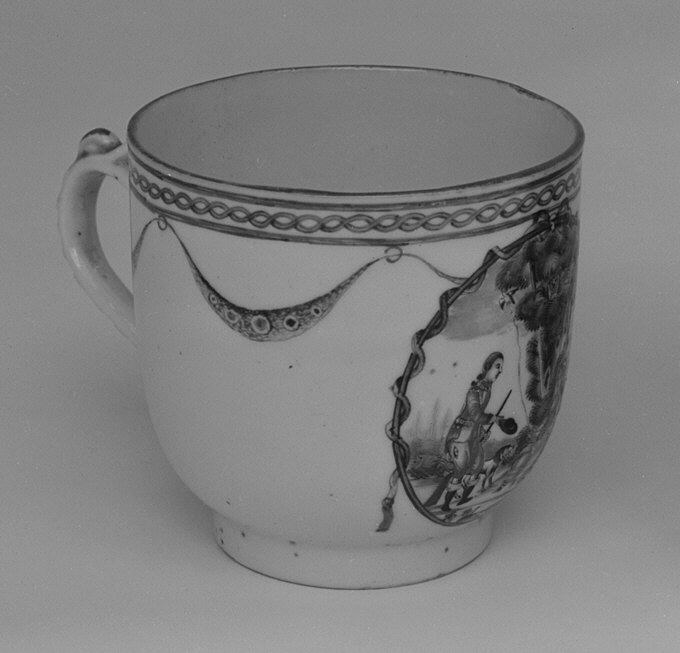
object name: cup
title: Cup (part of a service)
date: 1750-1770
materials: hard paste porcelain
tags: men,dogs